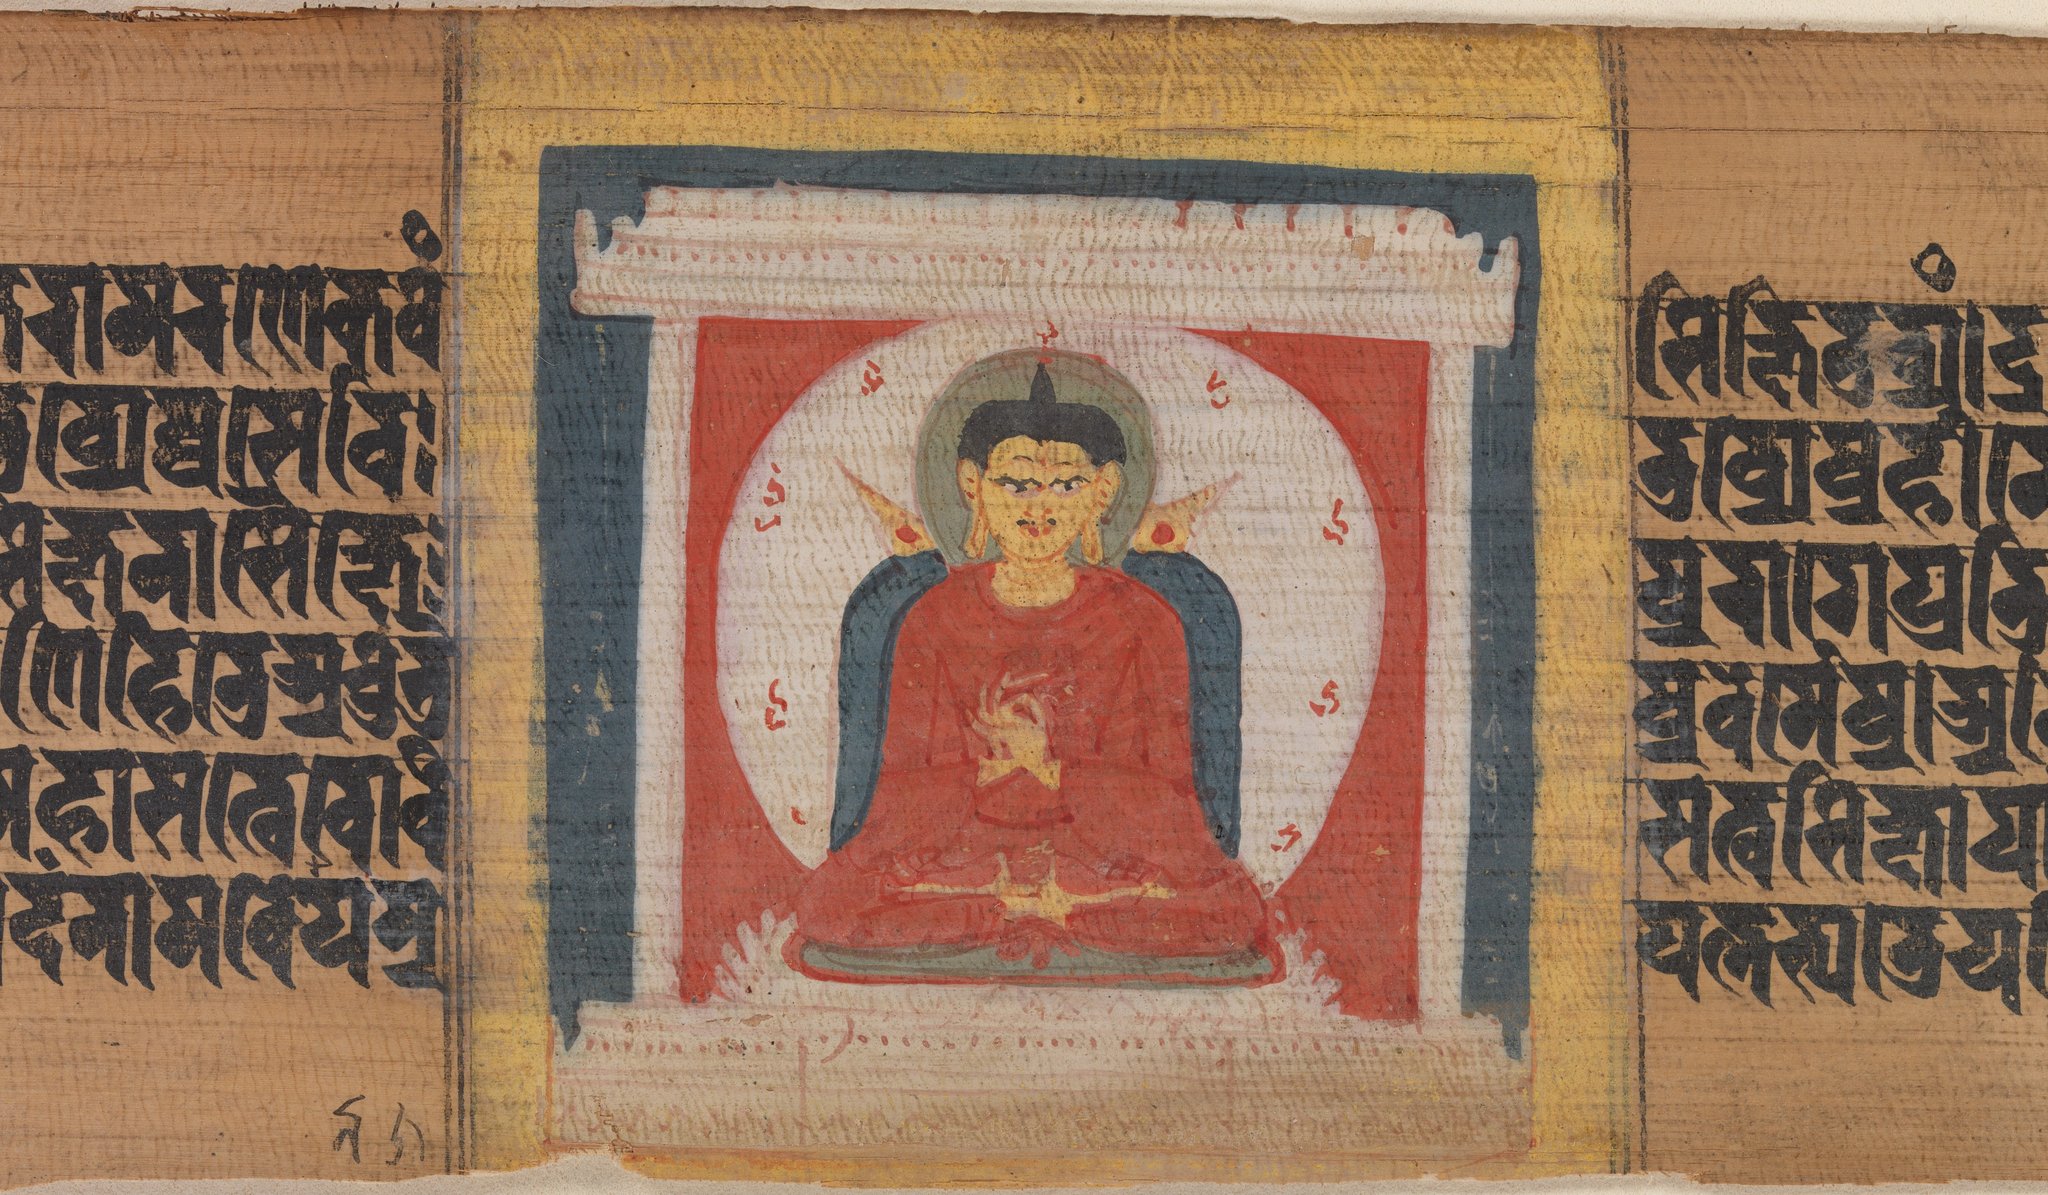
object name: folio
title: Buddha Enthroned in a Shrine, Leaf from a dispersed Pancavimsatisahasrika Prajnaparamita Manuscript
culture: indian, bengal or bangladesh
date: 1090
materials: leaf, watercolor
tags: buddhism,buddha